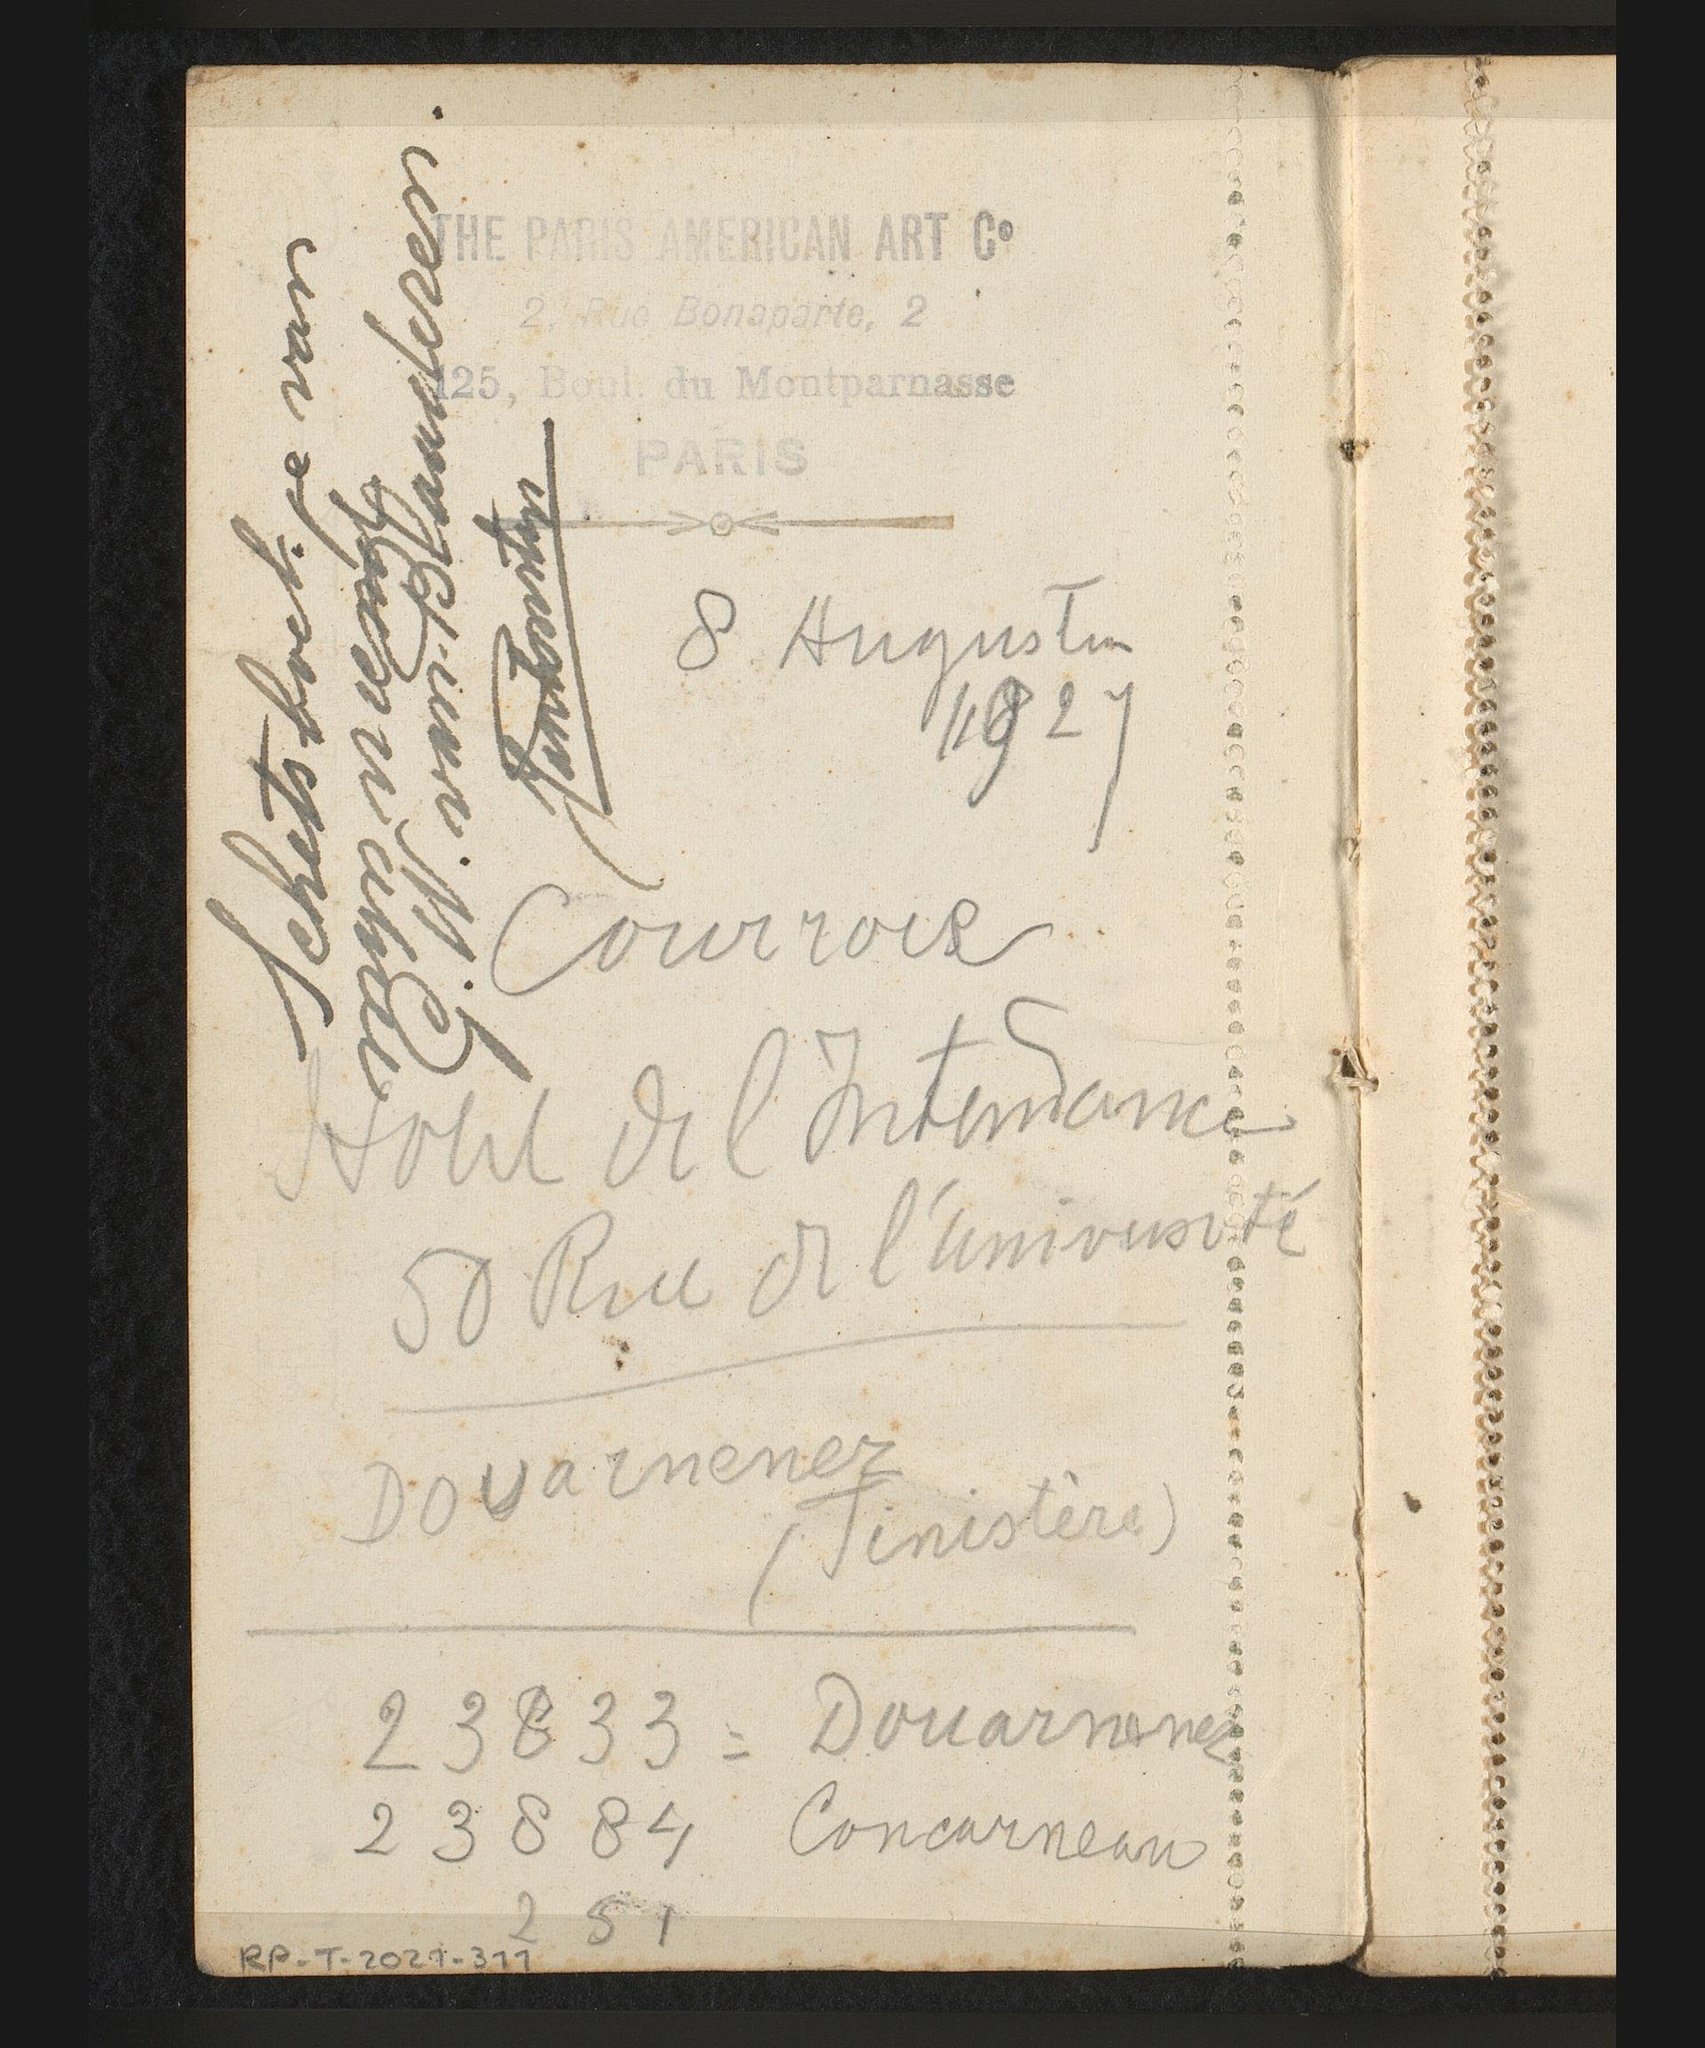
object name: endleaf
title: Notities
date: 1908-1927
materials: ink, paper, pencil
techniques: pen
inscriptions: inscription: ‘Schetsboekje van/ mijn vriend/ G.W. van Blaaderen./ Jan Ponstijn’, retailer's mark: ‘THE PARIS AMERICAN ART Co/ 2, Rue Bonaparte, 2/ 125, Boul. de Montparnasse/ PARIS’, date and inscription: ‘8 Augustus/ 1927 (...) 23884 Concarneau/ 251’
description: Voorste schutblad uit een schetsboek met 33 bladen.